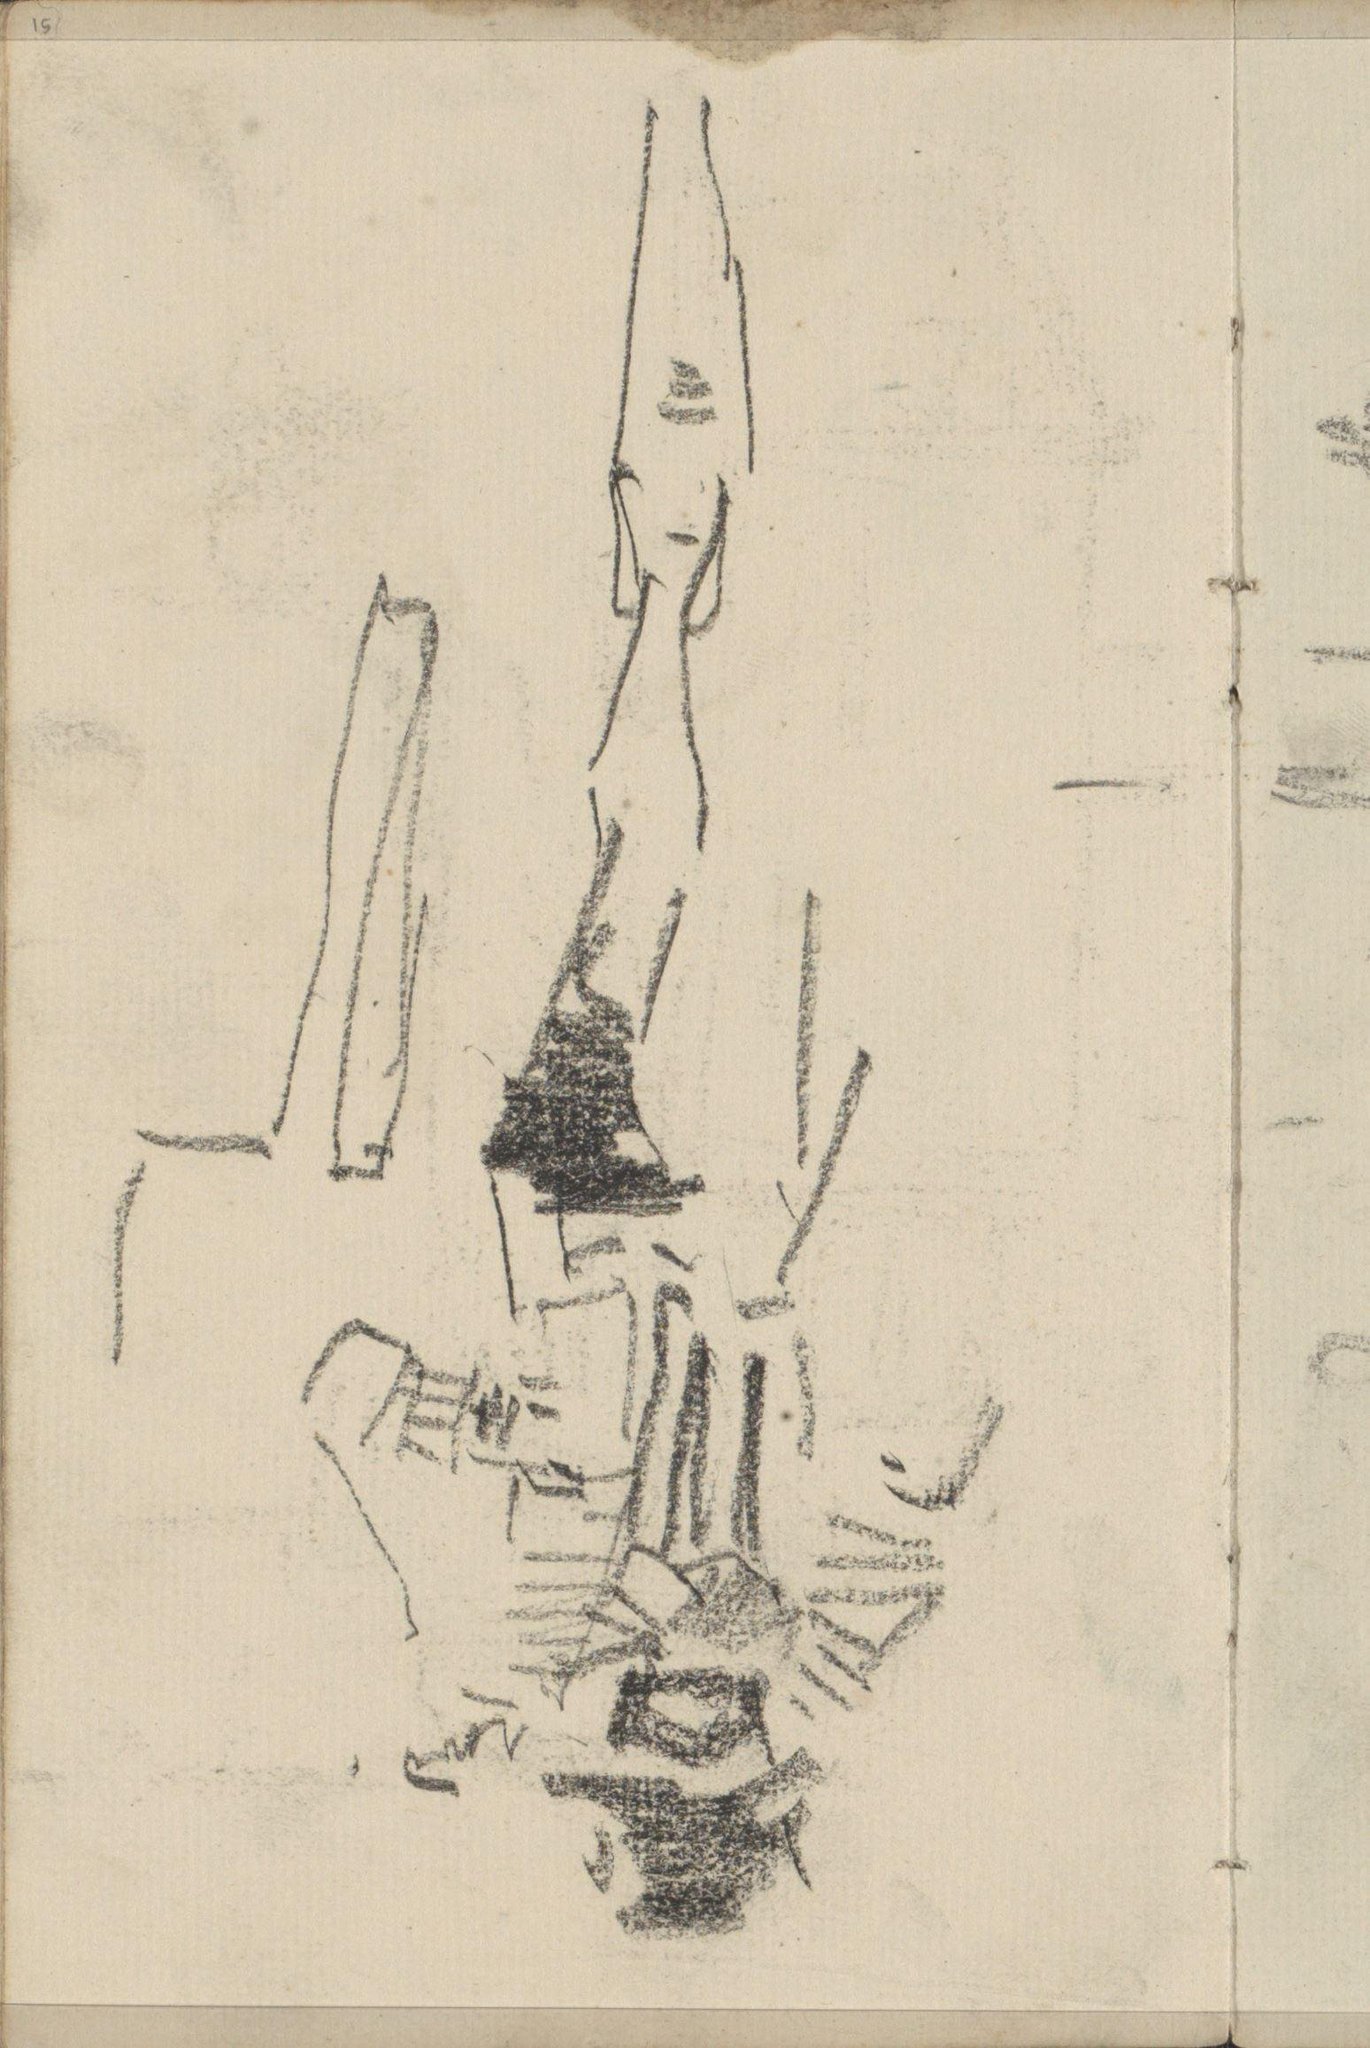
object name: sketchbook leaf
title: Staande man met hoed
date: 1882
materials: chalk, paper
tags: standing figure, head-gear: hat (+ men's clothes)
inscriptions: : ‘rood’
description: Pagina 15 uit een schetsboek met 31 bladen vervaardigd te Den Haag en Rotterdam.